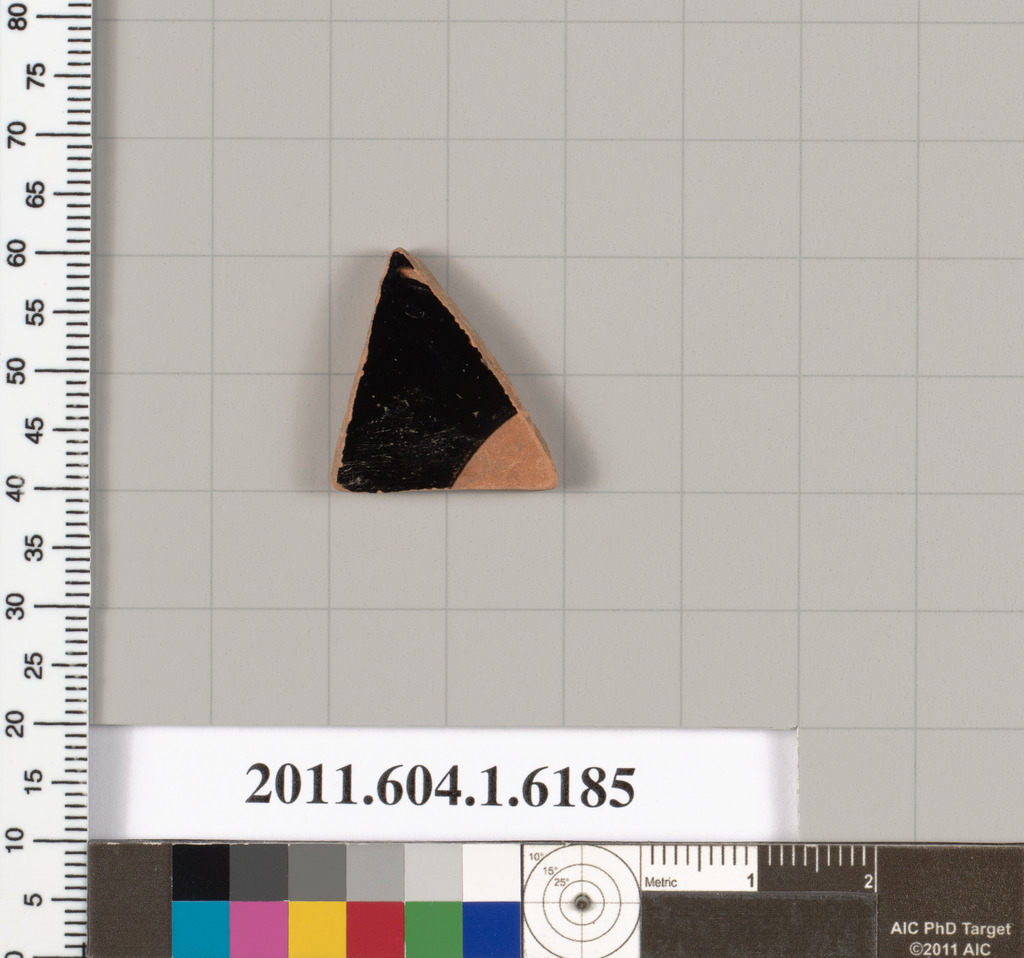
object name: kylix fragment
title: Terracotta fragment of a kylix (drinking cup)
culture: greek, attic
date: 520-500 BCE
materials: terracotta